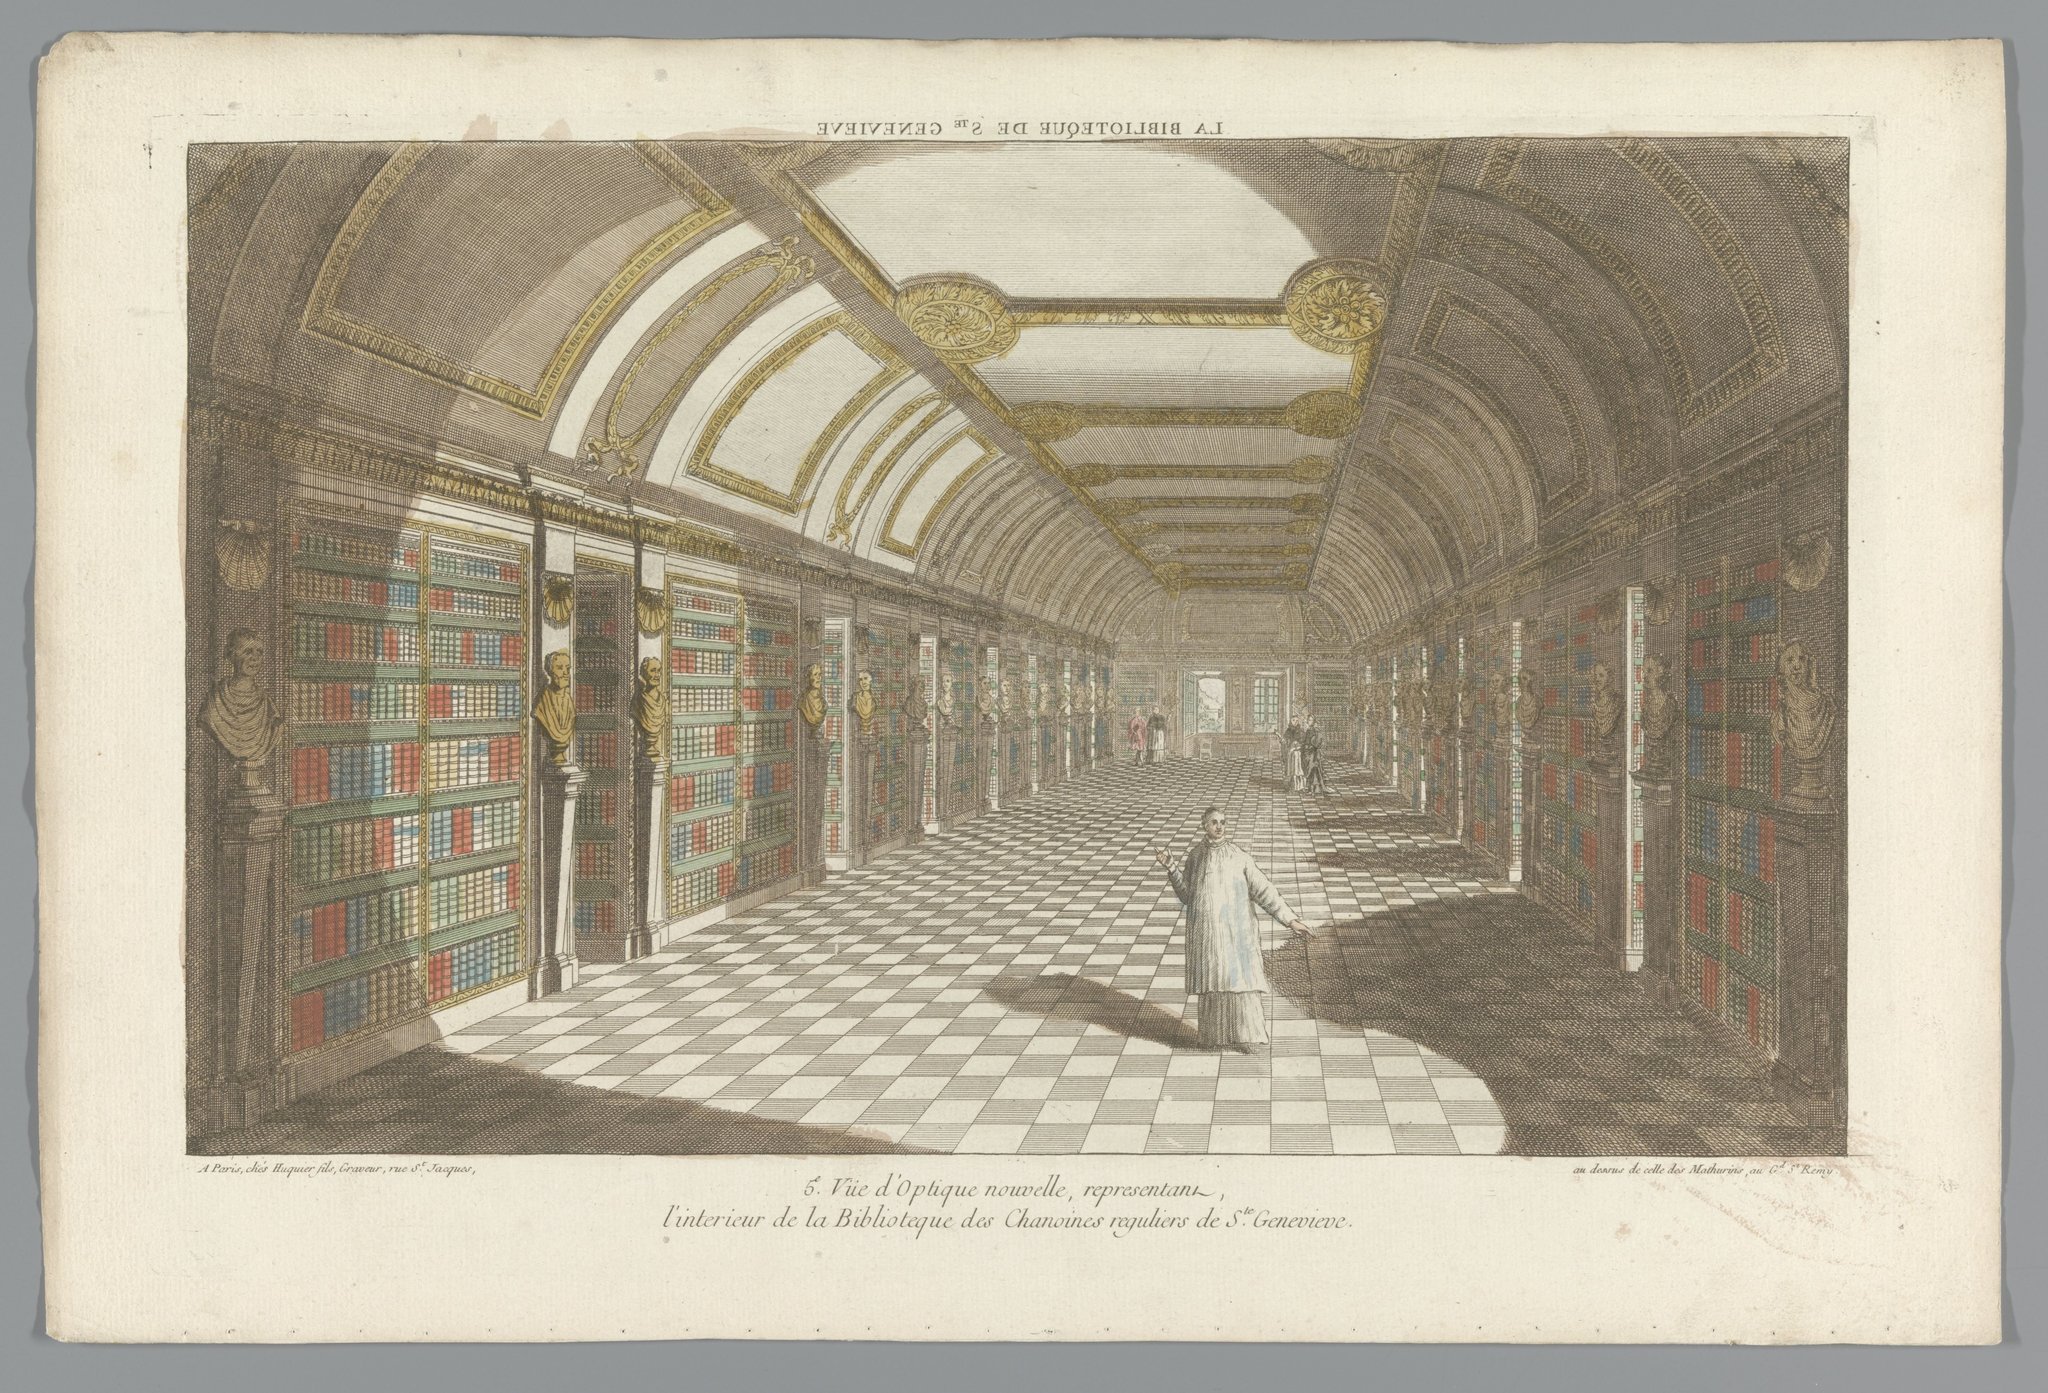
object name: opticaprent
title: Gezicht op de bibliotheek van de abdij Sainte-Geneviève te Parijs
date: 1735-1805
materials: paper, watercolor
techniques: brush, etching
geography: paris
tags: abbey, monastery, convent ~ roman catholic church, monk(s), friar(s), study; 'studiolo'; library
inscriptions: collector's mark: Lugt 2166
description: In de bibliotheek loopt een aantal reguliere kanunniken. Genummerd: 5.